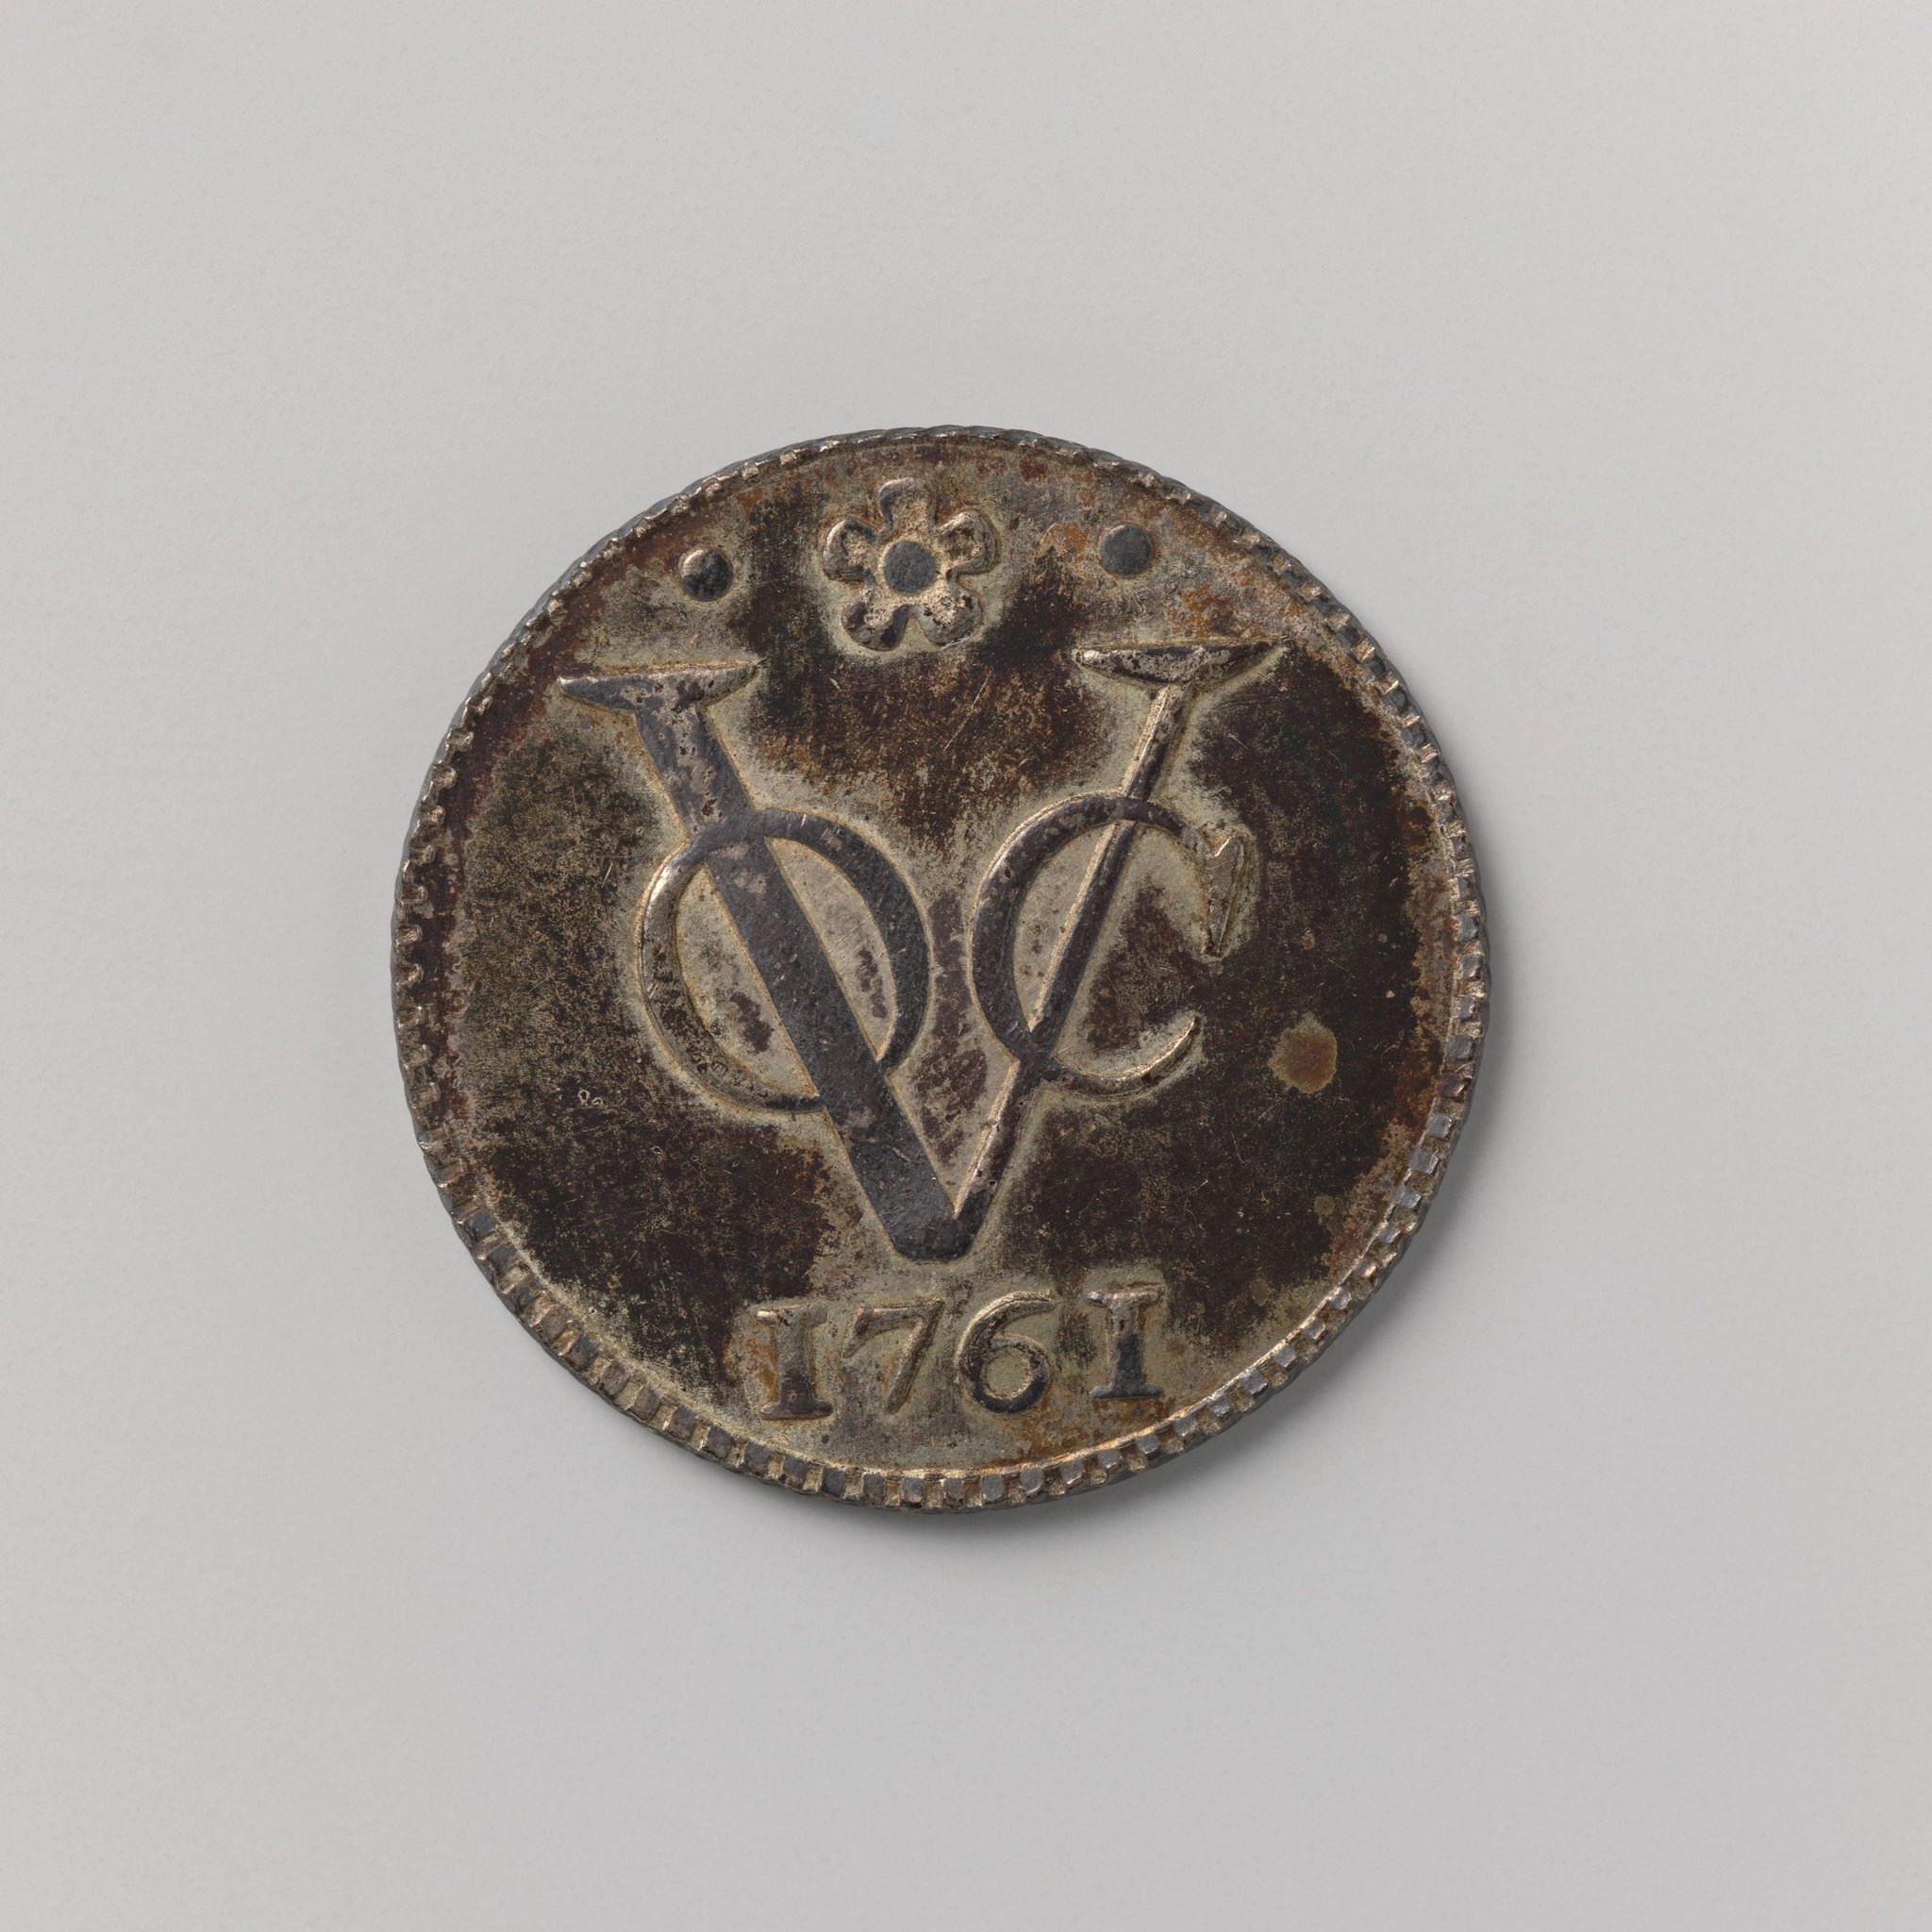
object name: coin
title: Afslag in zilver van een duit van de VOC uit Holland, 1761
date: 1761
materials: silver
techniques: striking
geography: dordrecht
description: Zilveren munt. Voorzijde: gekroond wapenschild van Holland. Keerzijde: monogram van de VOC, waarboven muntteken en waaronder jaartal. Kabelrand. Afslag in zilver.